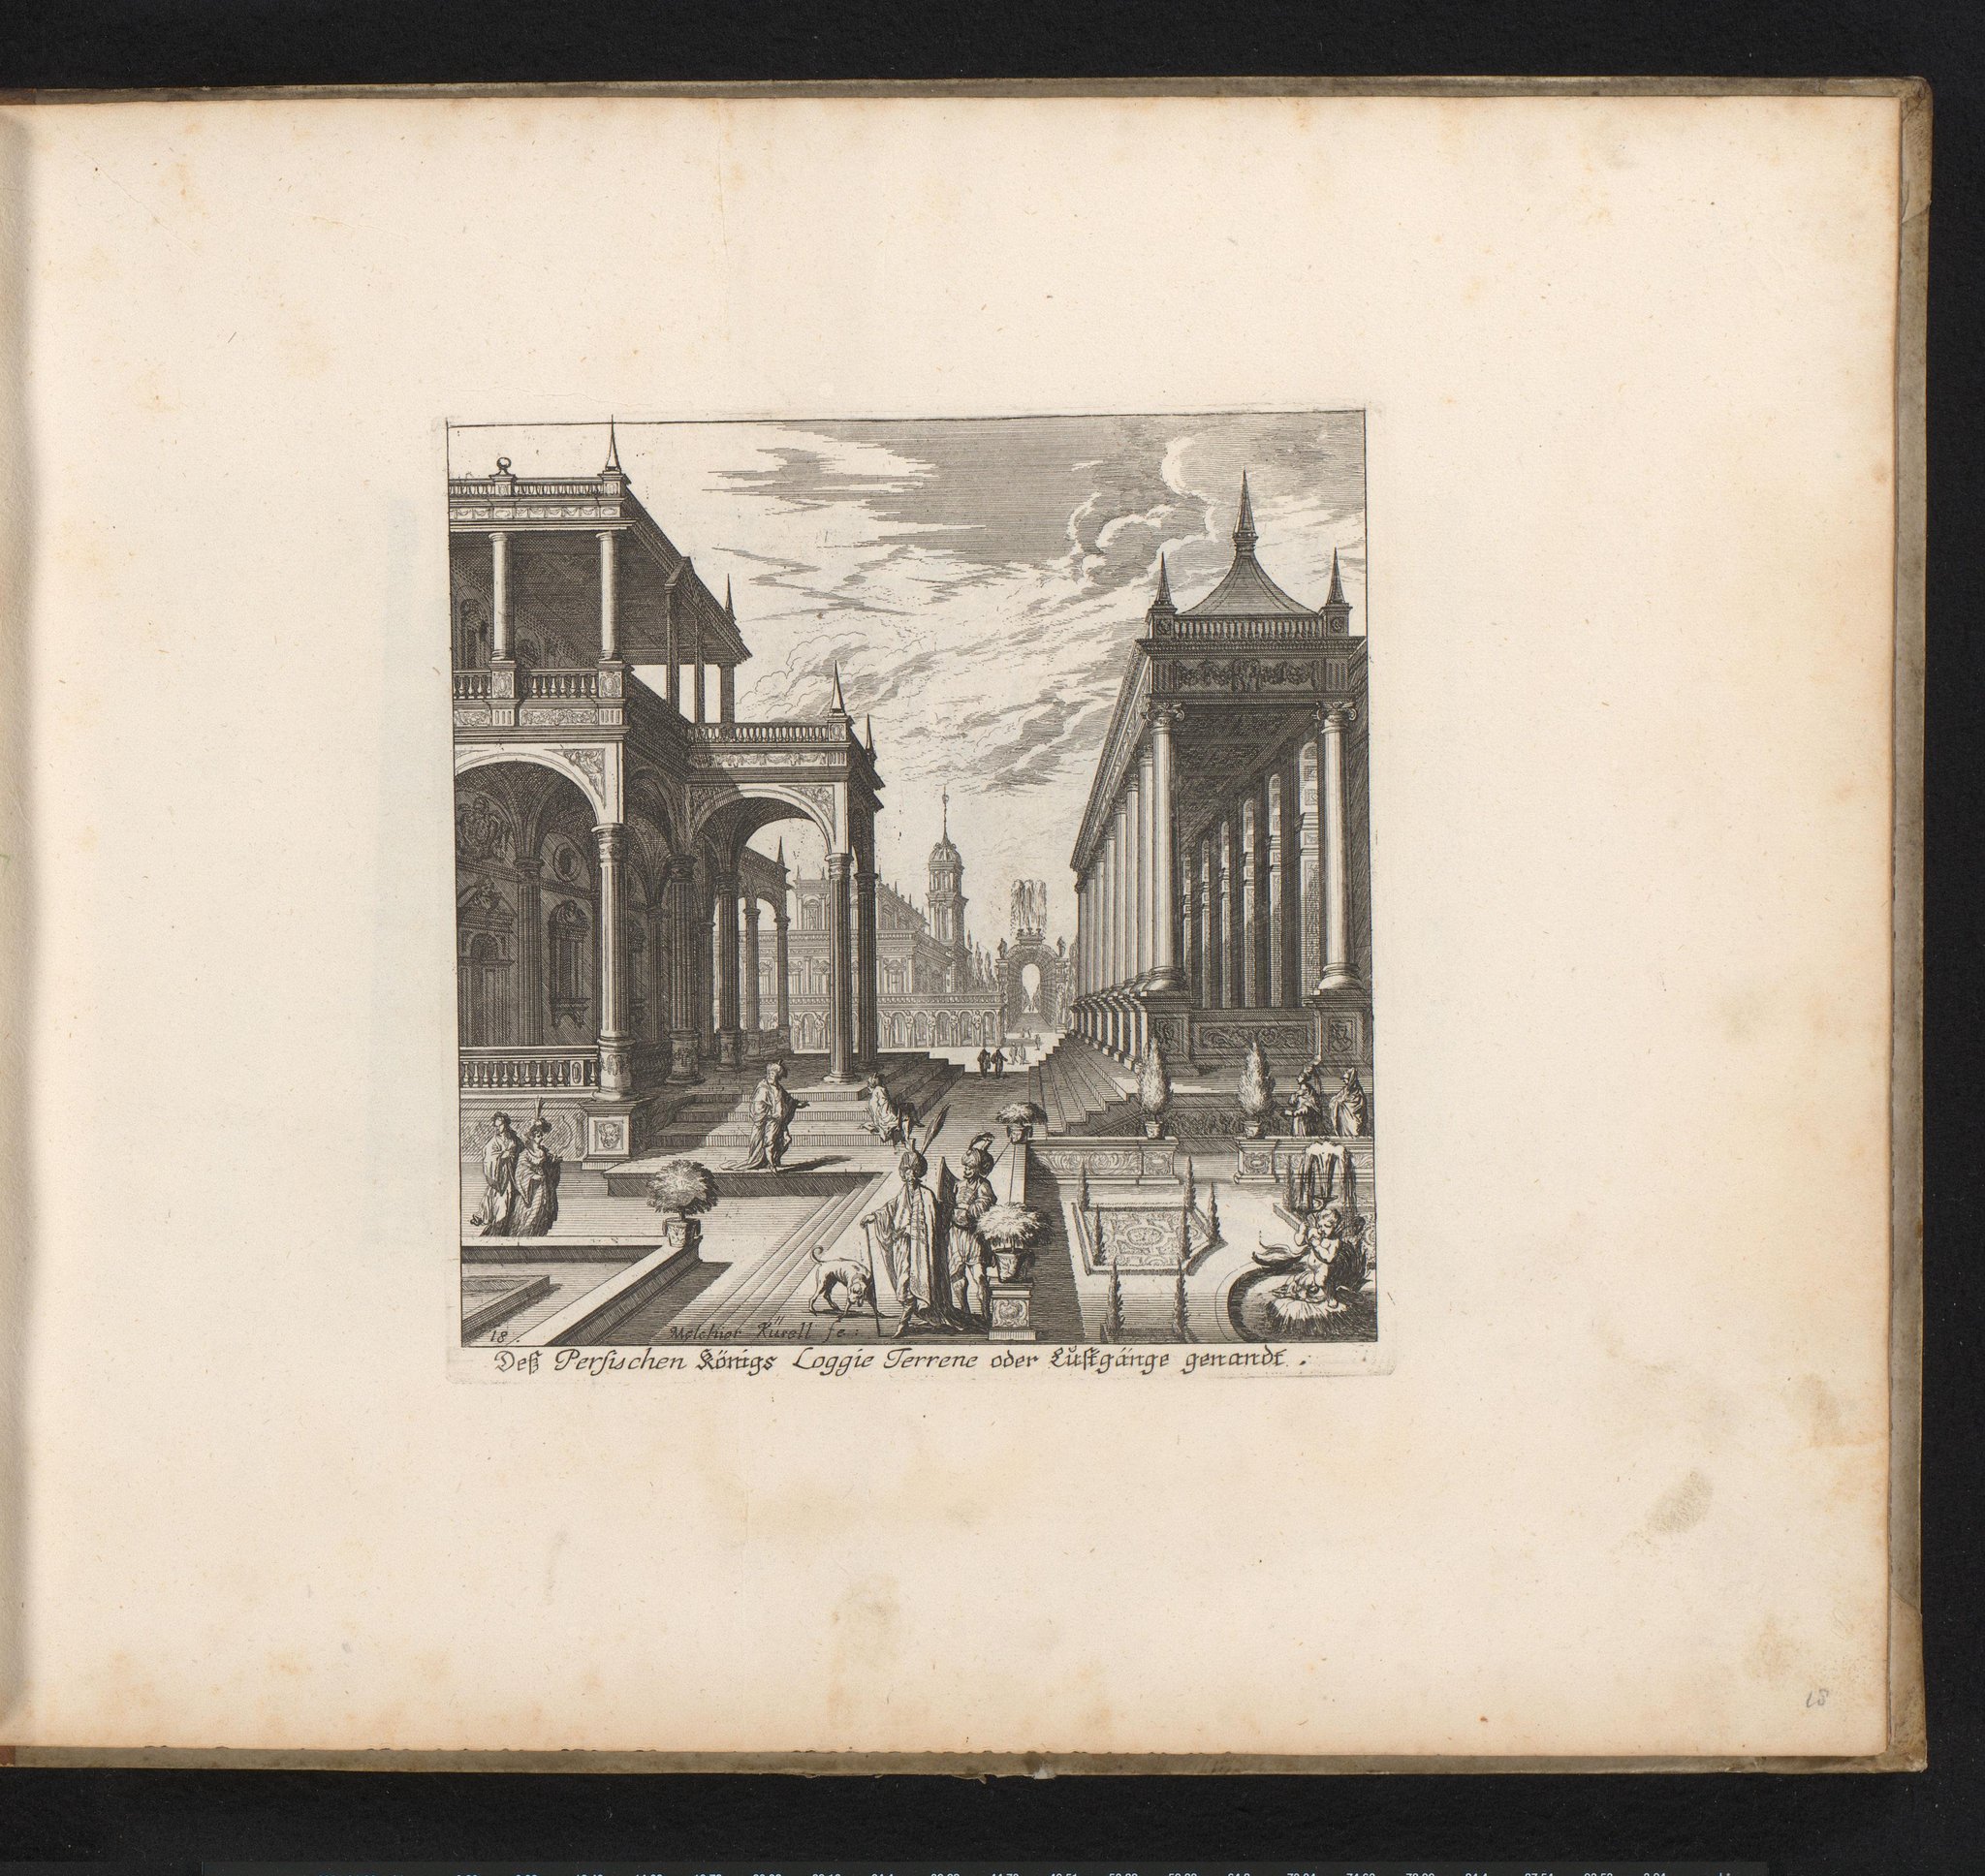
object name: album leaf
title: Gezicht op loggia's in Romeinse stijl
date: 1670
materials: paper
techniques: etching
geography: augsburg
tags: head-gear: turban, loggia, verandah, porch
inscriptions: collector's mark: Lugt 2228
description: Tekst in het Duits in de ondermarge. Rechtsonder genummerd: 18. Prent maakt deel uit van een album.